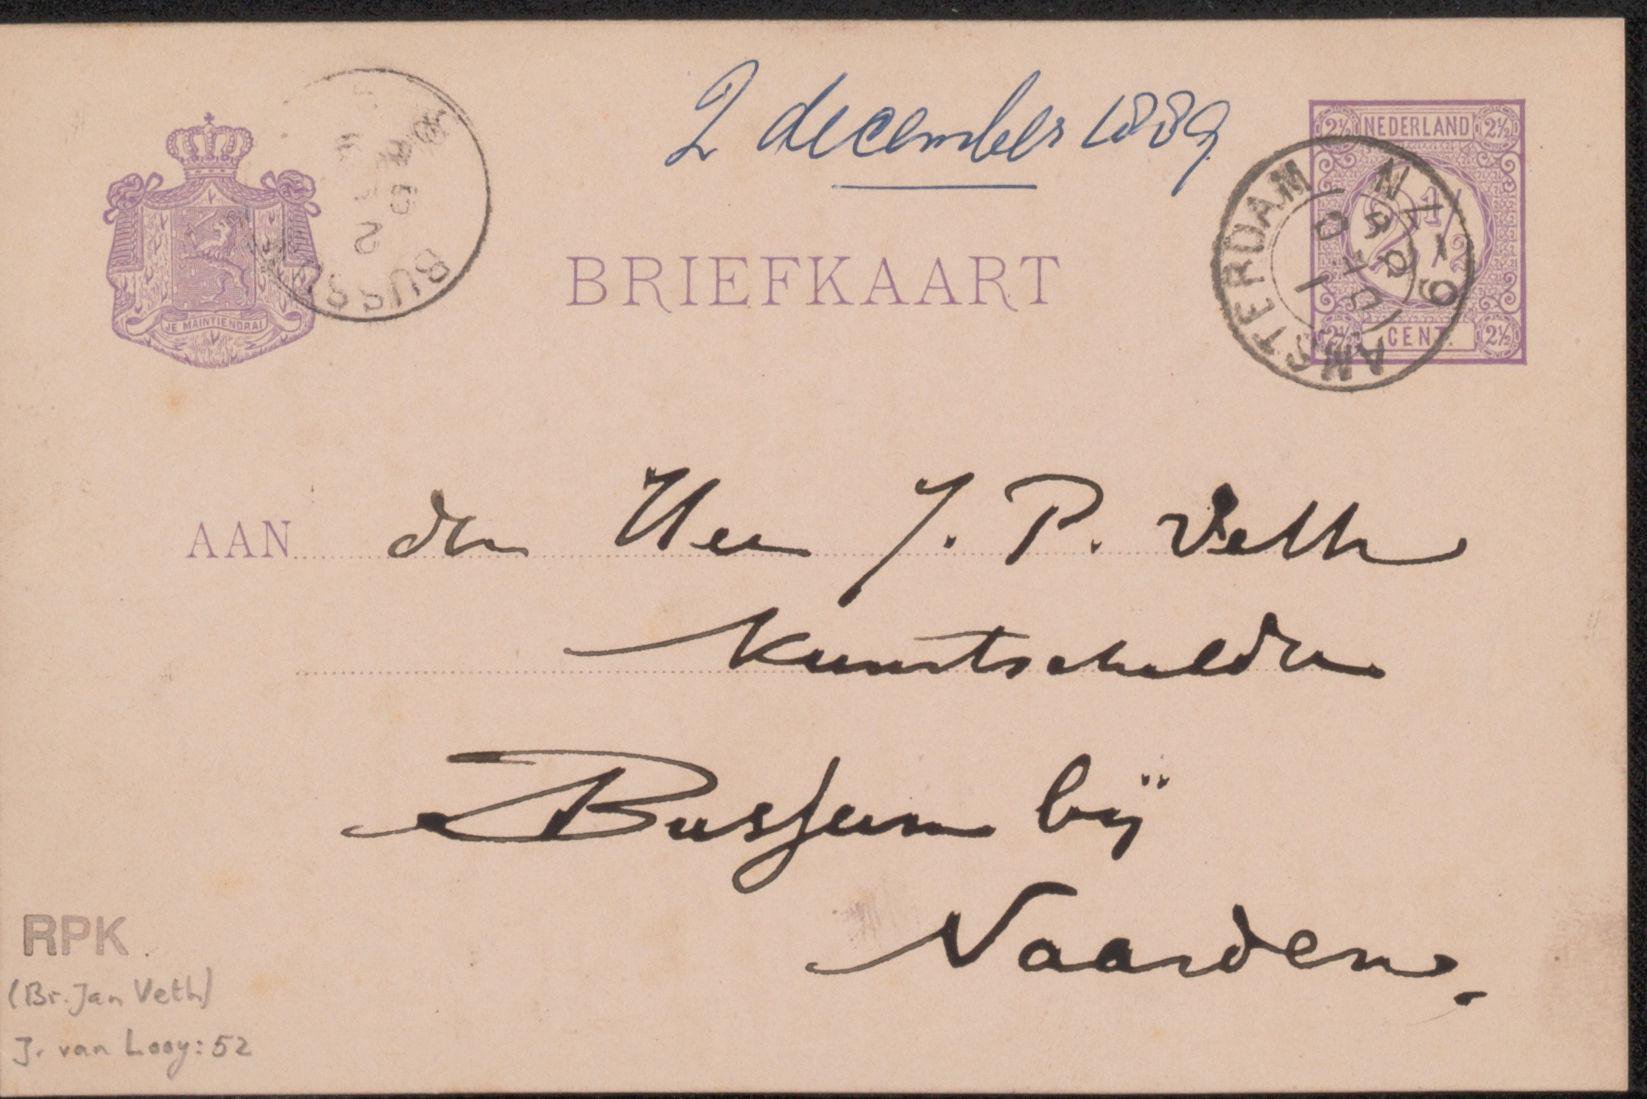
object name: postcard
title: Briefkaart aan Jan Veth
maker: jac van looij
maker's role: draughtsman, painter, print maker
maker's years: 1855-1930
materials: cardboard, ink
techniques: pen, writing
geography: amsterdam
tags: dordrecht, amsterdam, designer, jan veth, saskia delprat-veth, family life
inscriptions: collector's mark: ‘RPK’